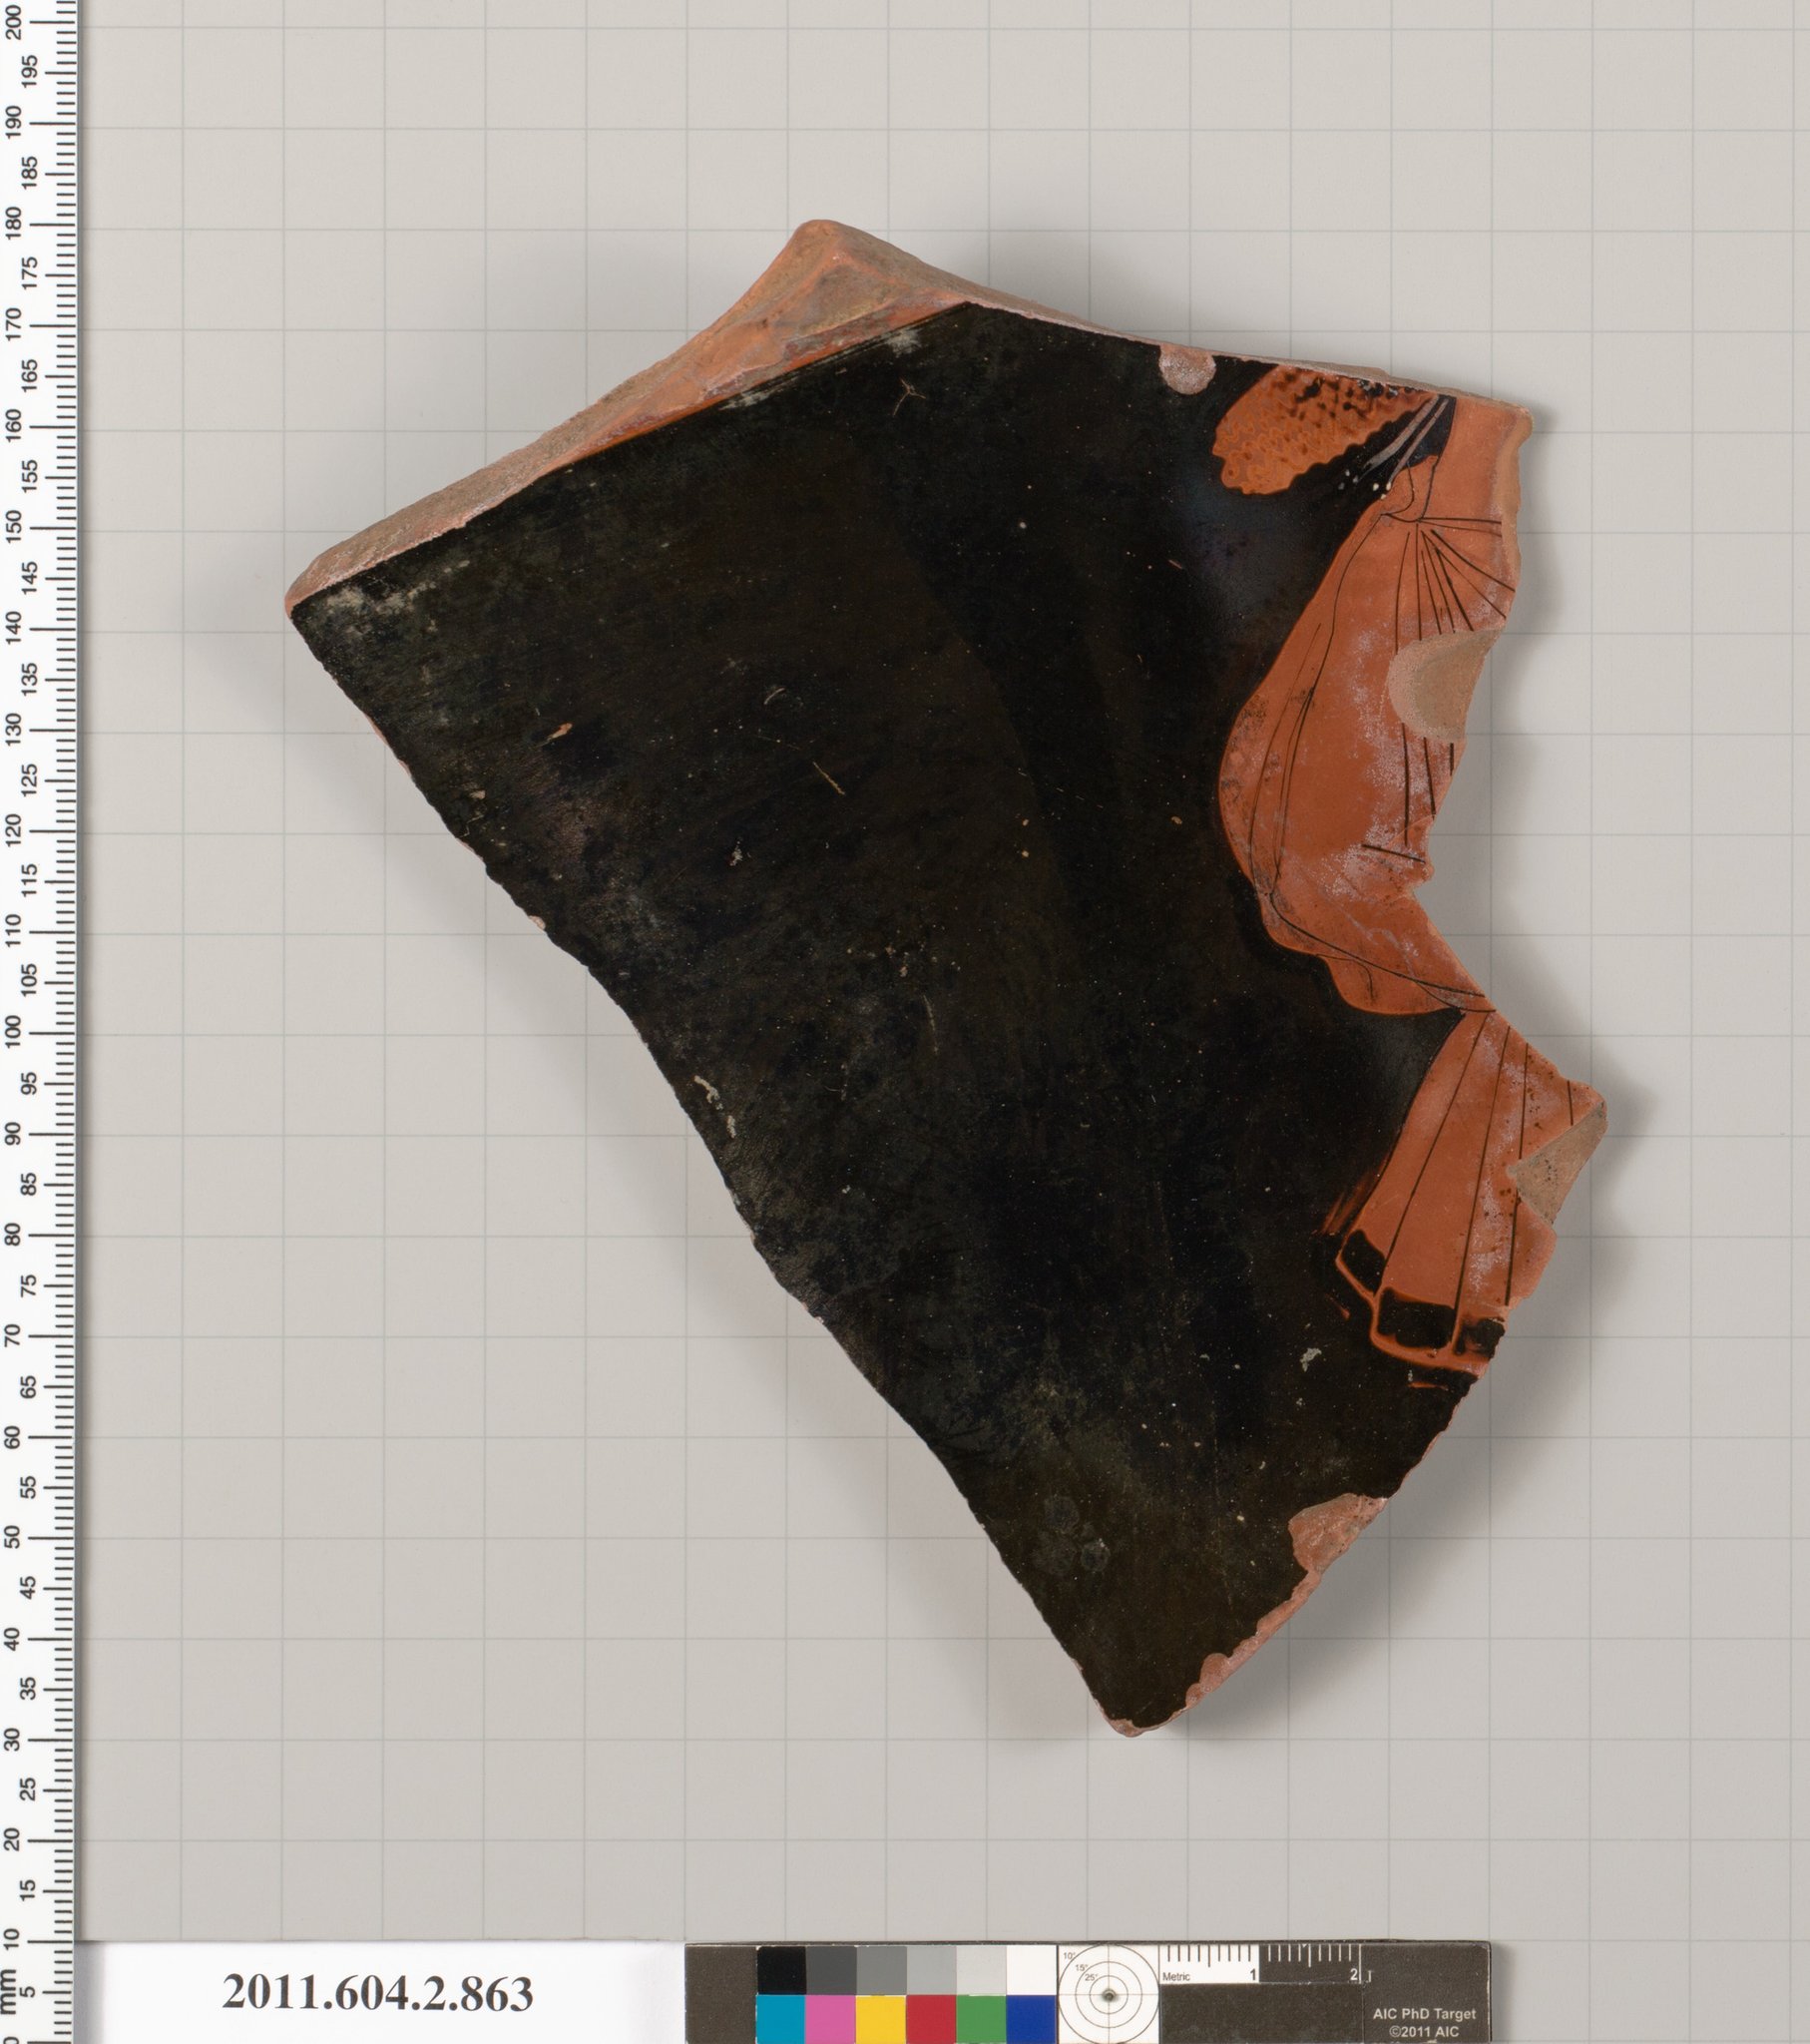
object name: bell krater fragment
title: Terracotta fragment of a bell-krater (bowl for mixing wine and water)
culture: greek, attic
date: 470-460 BCE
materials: terracotta